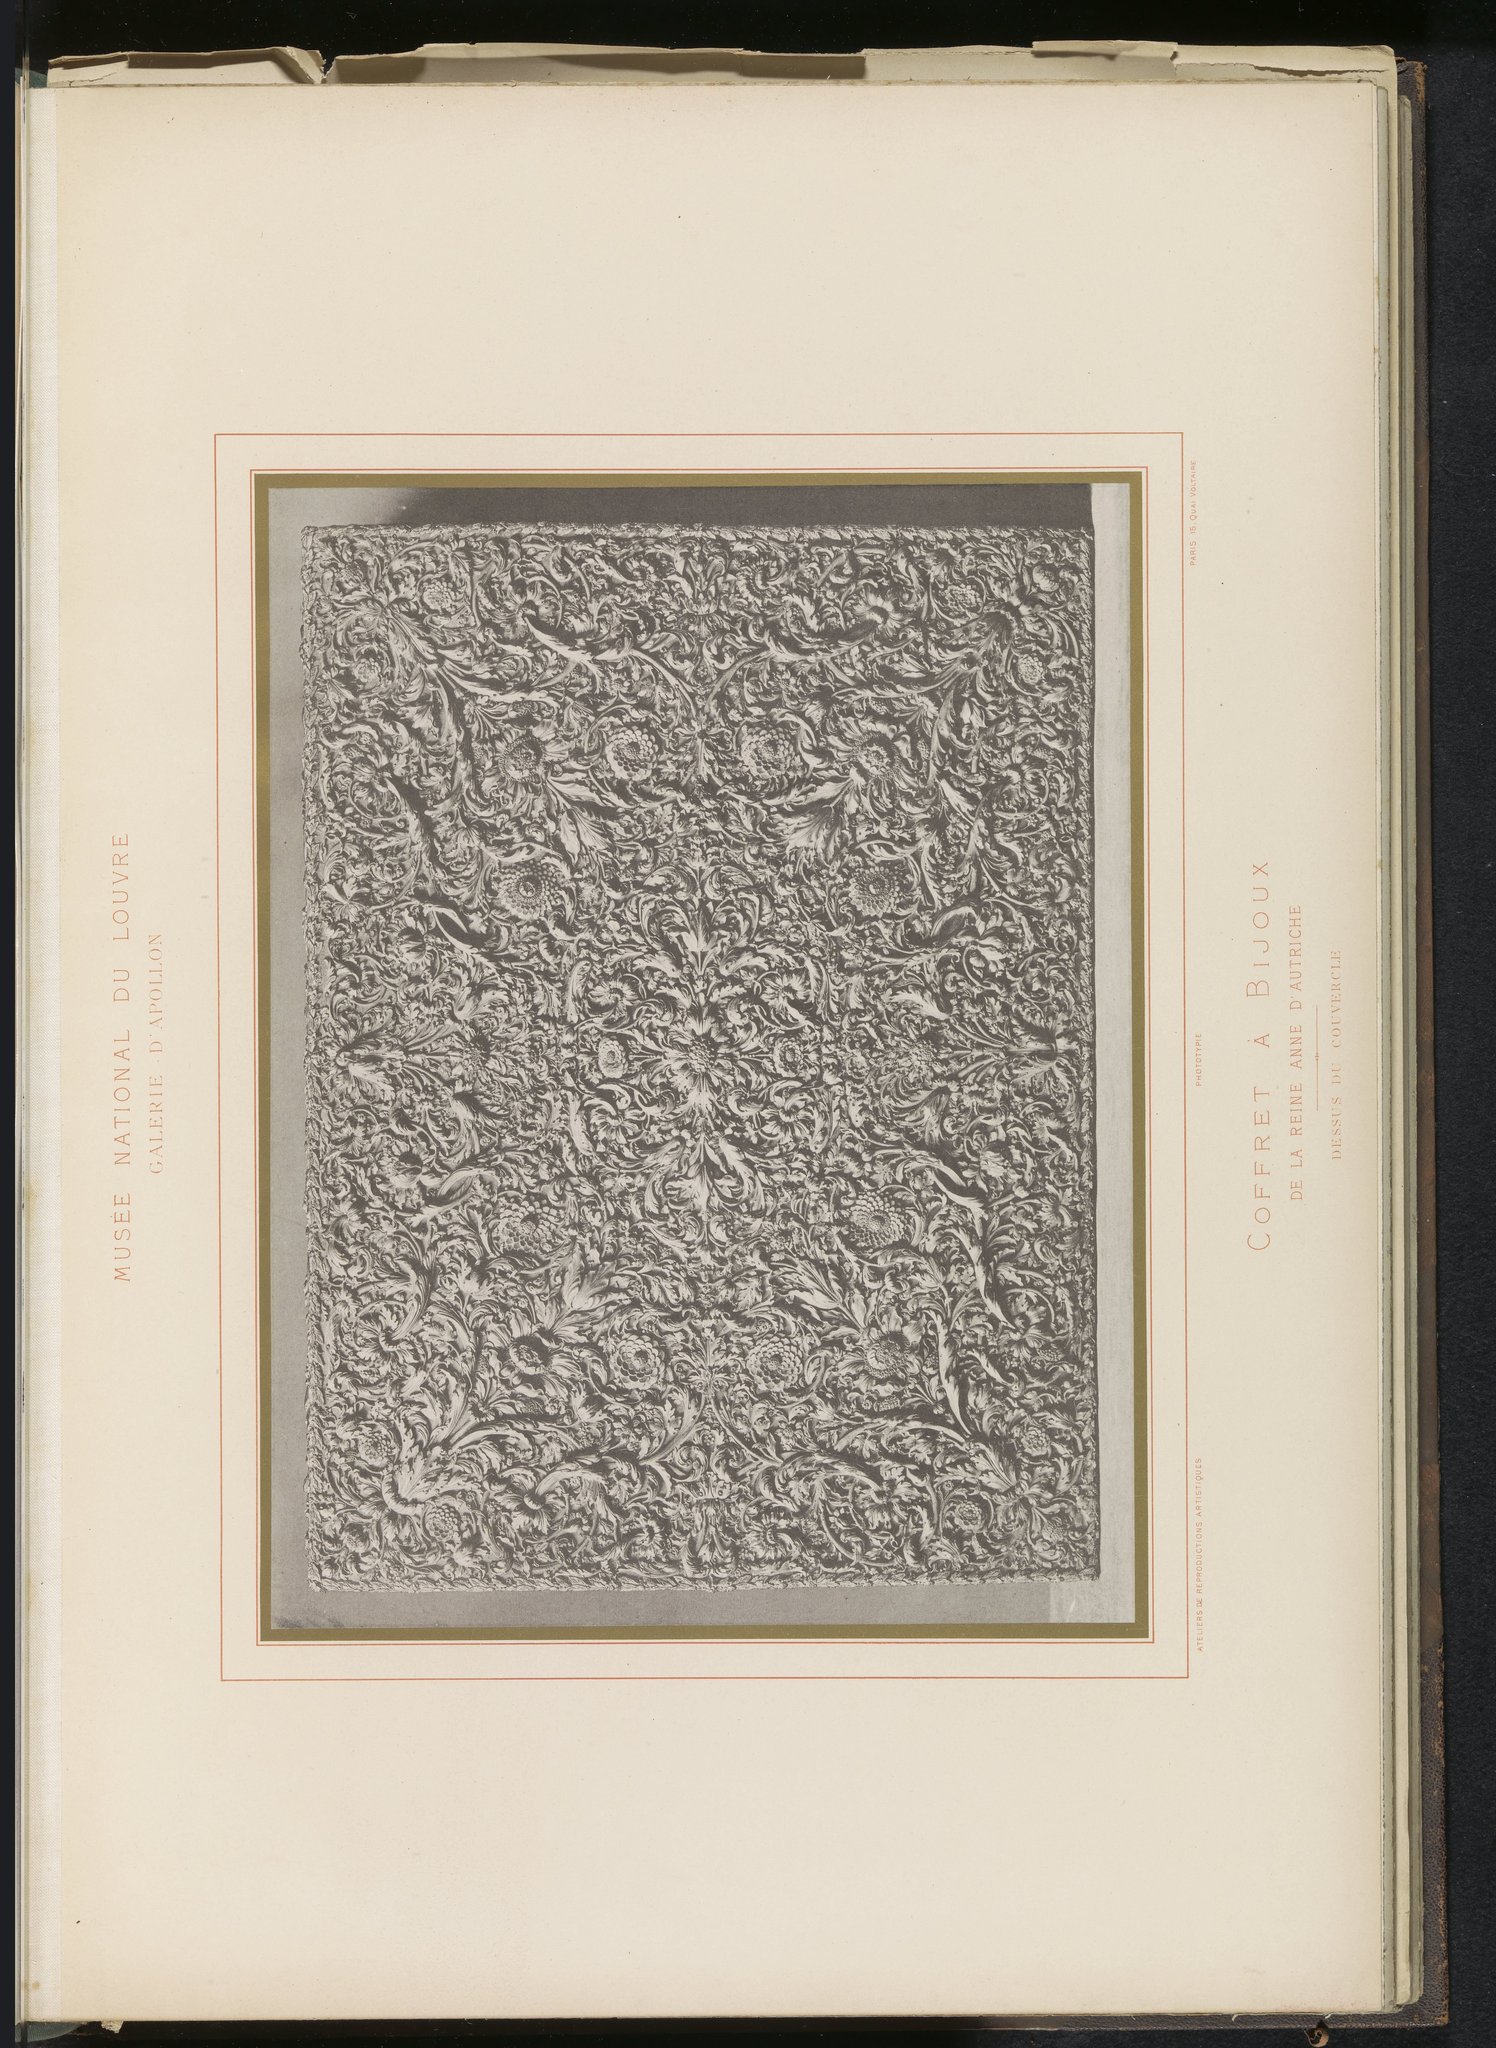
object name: page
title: Coffret à bijoux de la reine Anne d'Autriche femme de Louis XIII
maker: léon vidal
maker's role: fotograaf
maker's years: 1833-1906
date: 1876-1883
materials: paper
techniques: photograph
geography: paris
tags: floral interlace ~ ornament, chasing, embossing (industrial process), jewel-box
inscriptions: inscription: ‘dessus du couvercie’, inscription: ‘ateliers de reproductions artistiques’